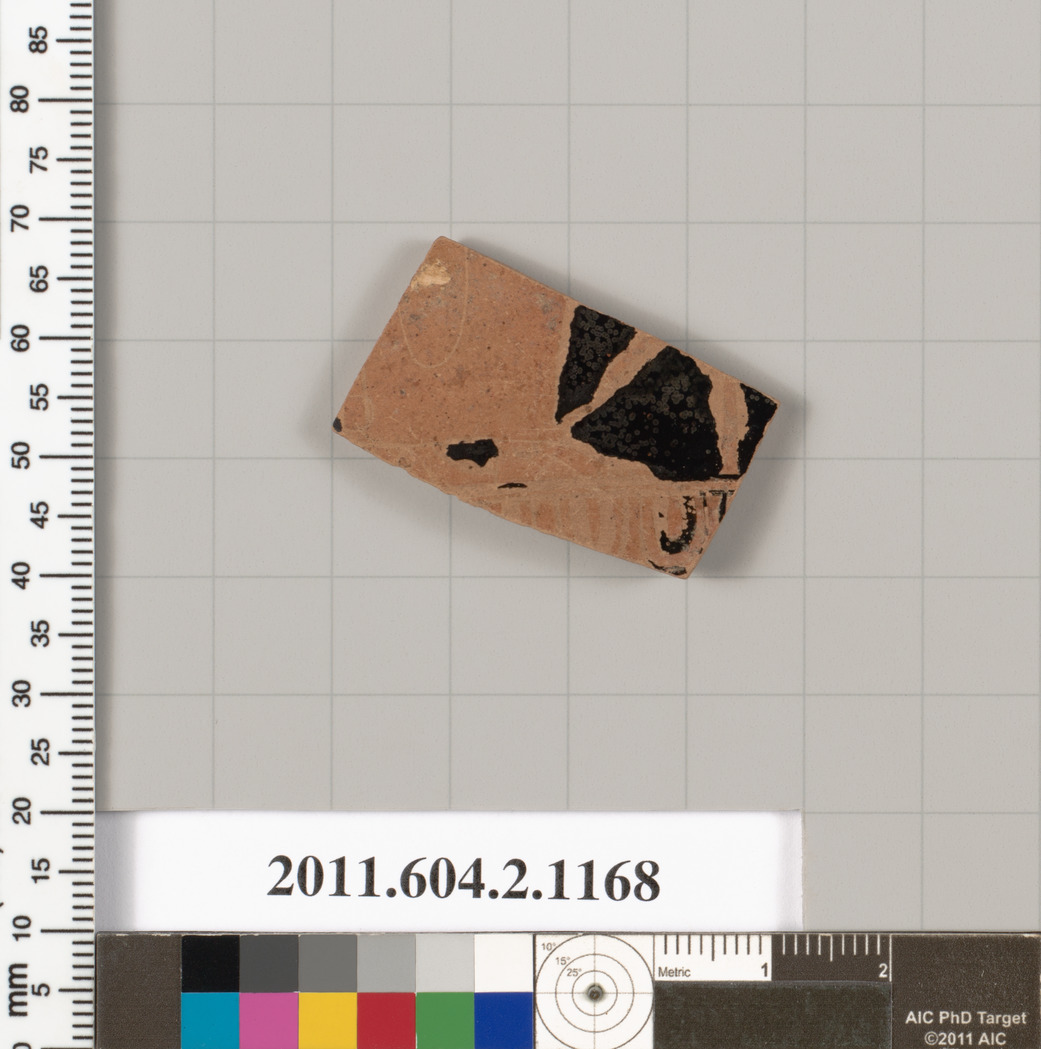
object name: skyphos fragment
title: Terracotta fragment of a skyphos (deep drinking cup)?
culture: greek, attic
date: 460-440 BCE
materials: terracotta